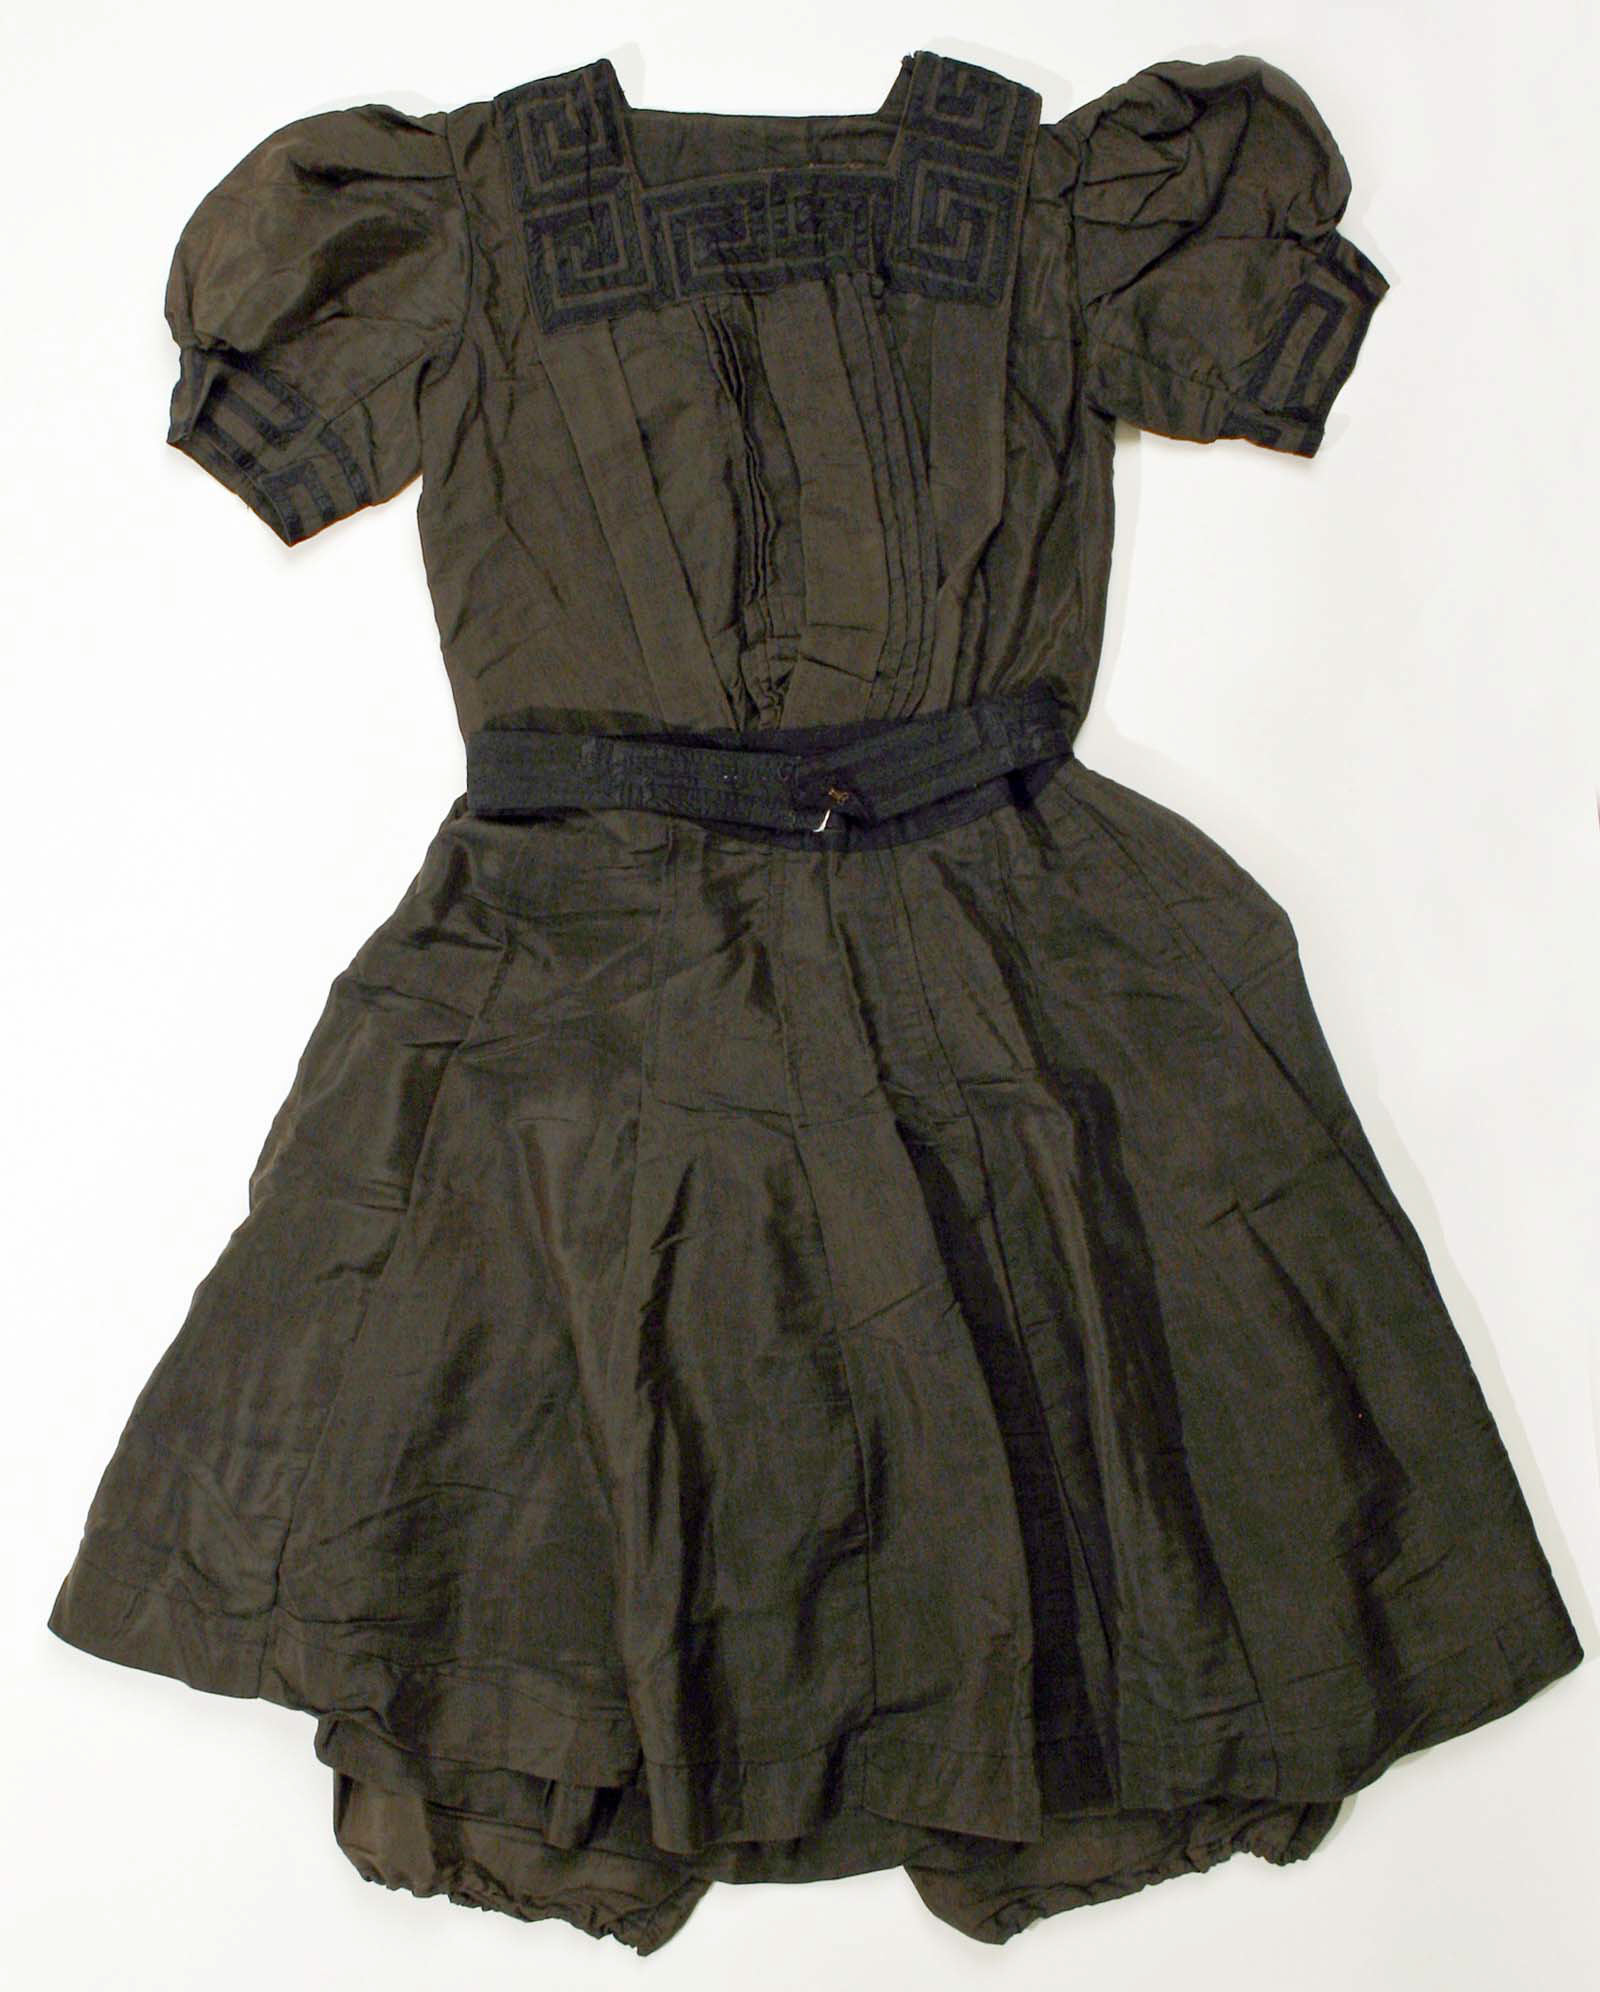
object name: bathing suit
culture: american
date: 1900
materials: wool